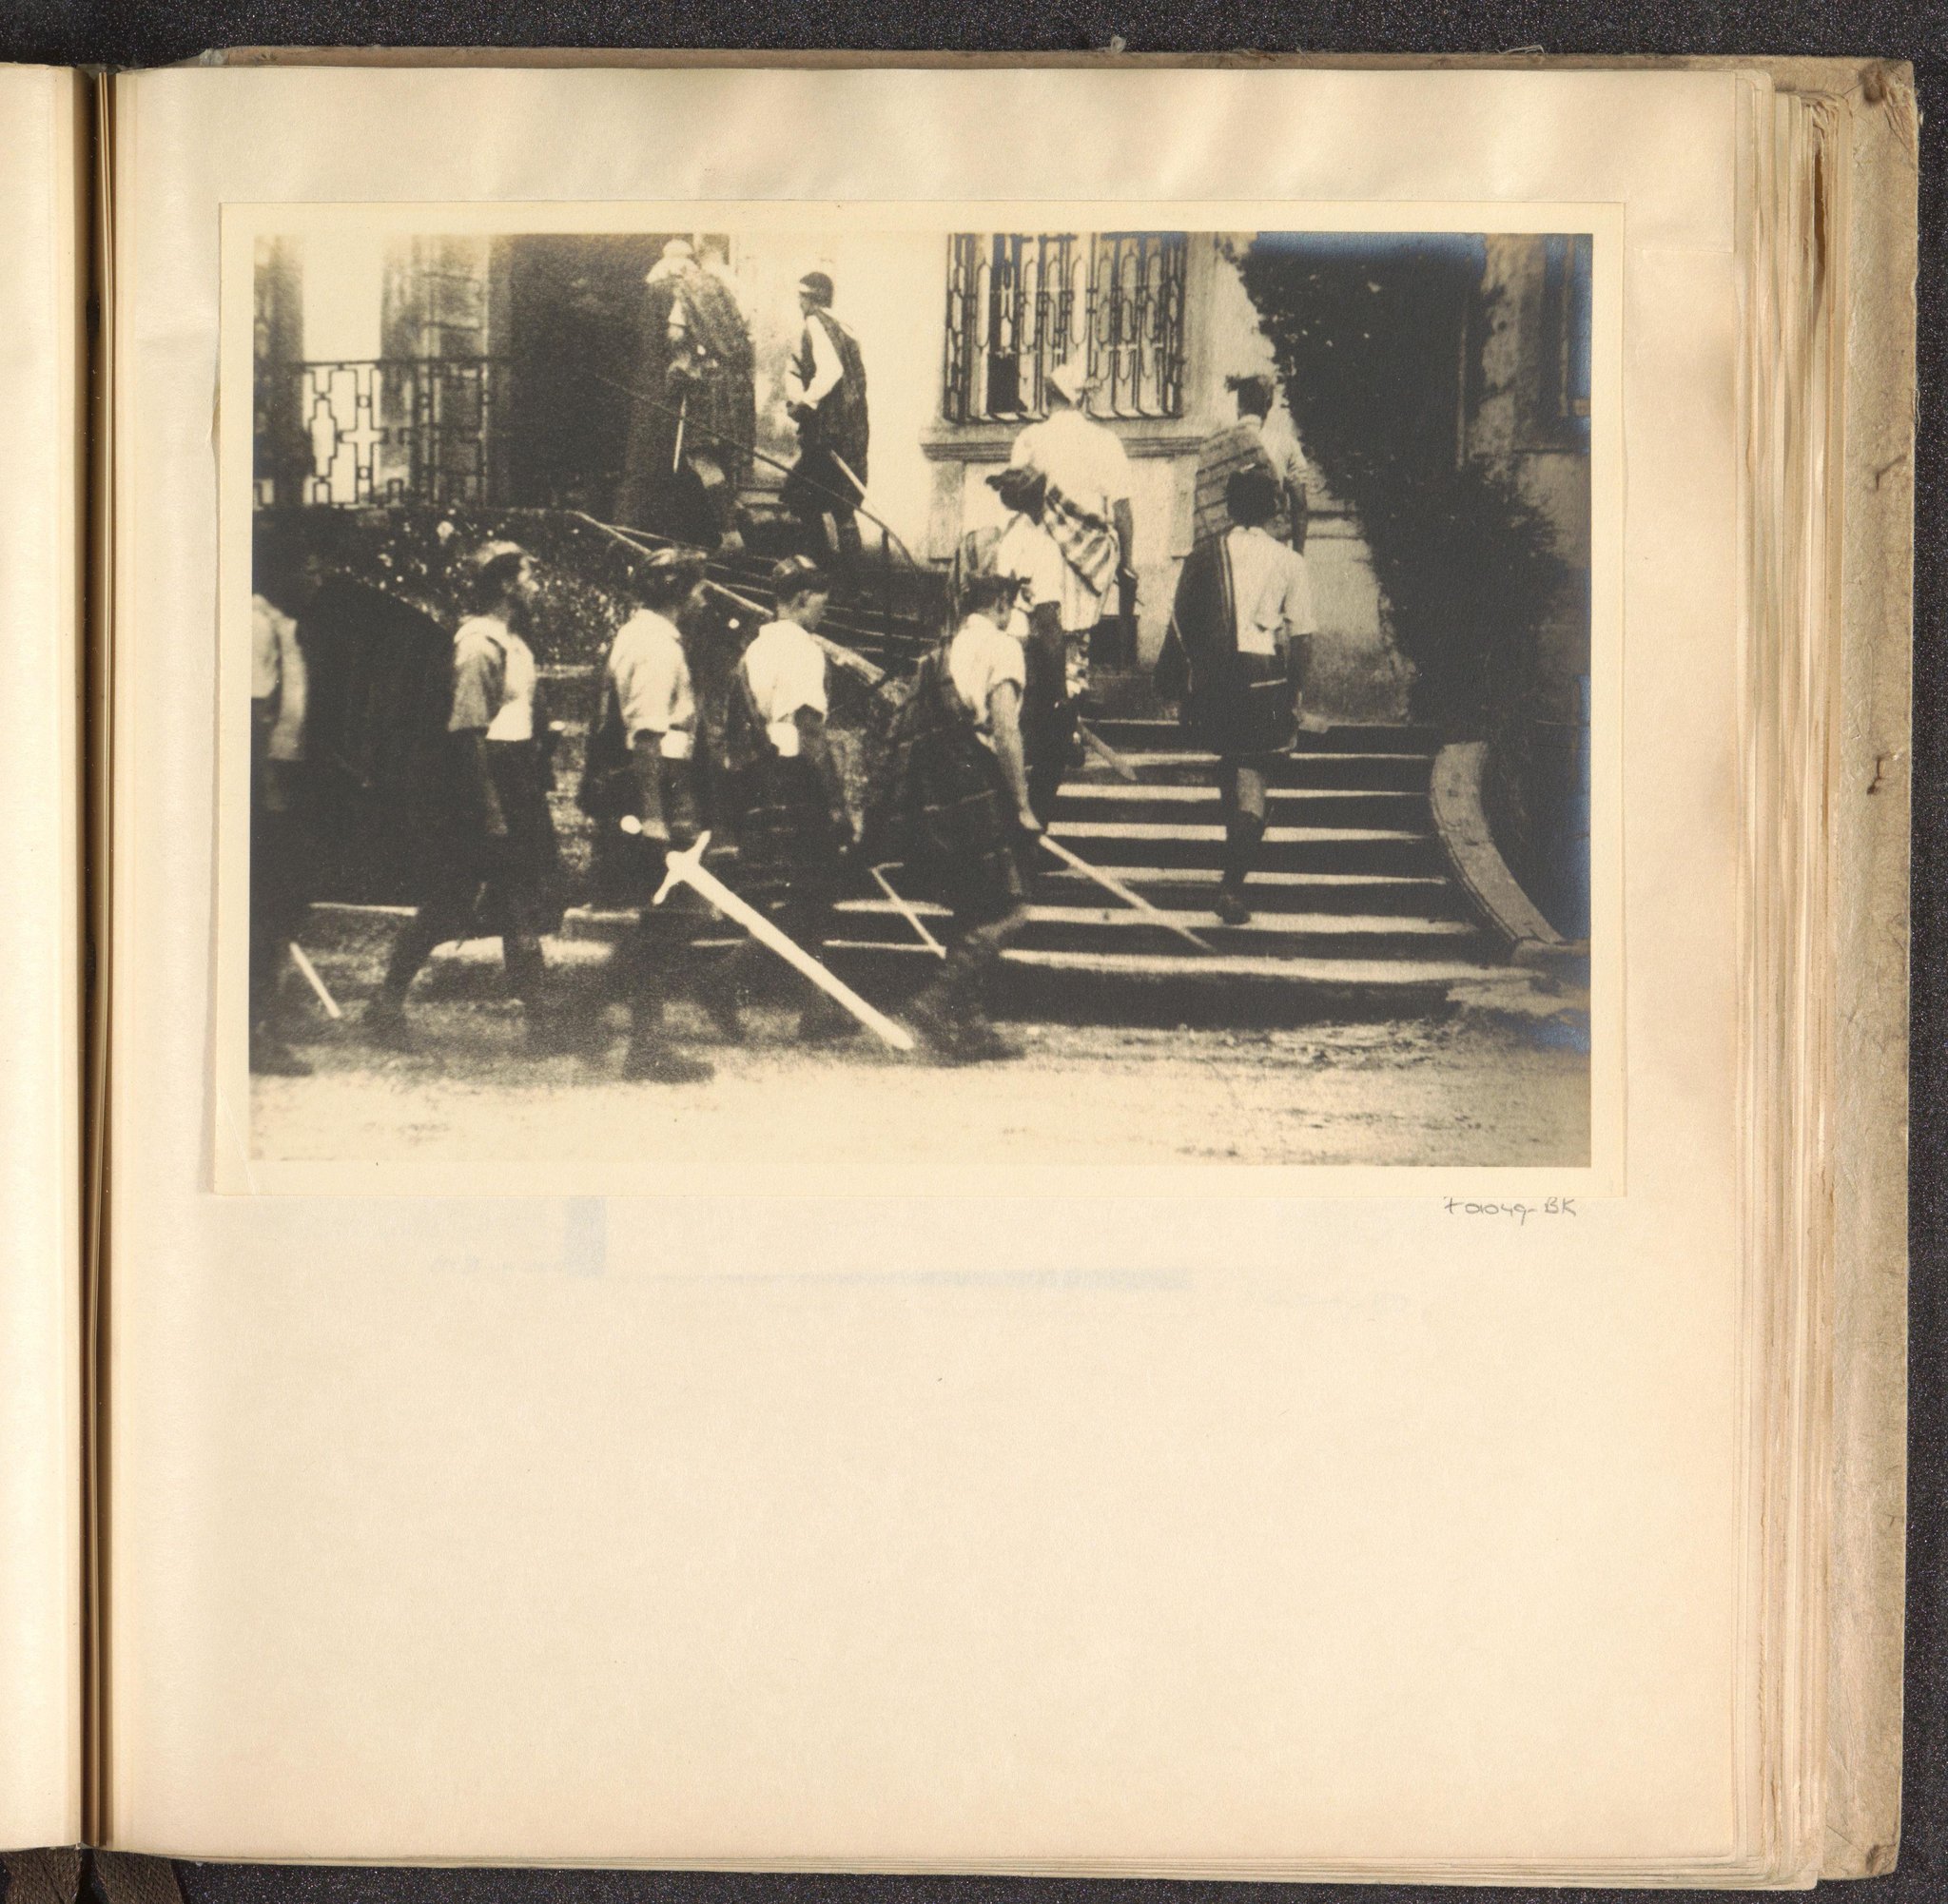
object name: photograph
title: Leerlingen van Schule Schloss Salem tijdens een dramatische uitvoering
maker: Anonymous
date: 1929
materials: photographic support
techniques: gelatin silver print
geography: salem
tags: performance, theatre, theatrical performance, historical costume, education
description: Onderdeel van Fotoalbum van Schule Schloss Salem.